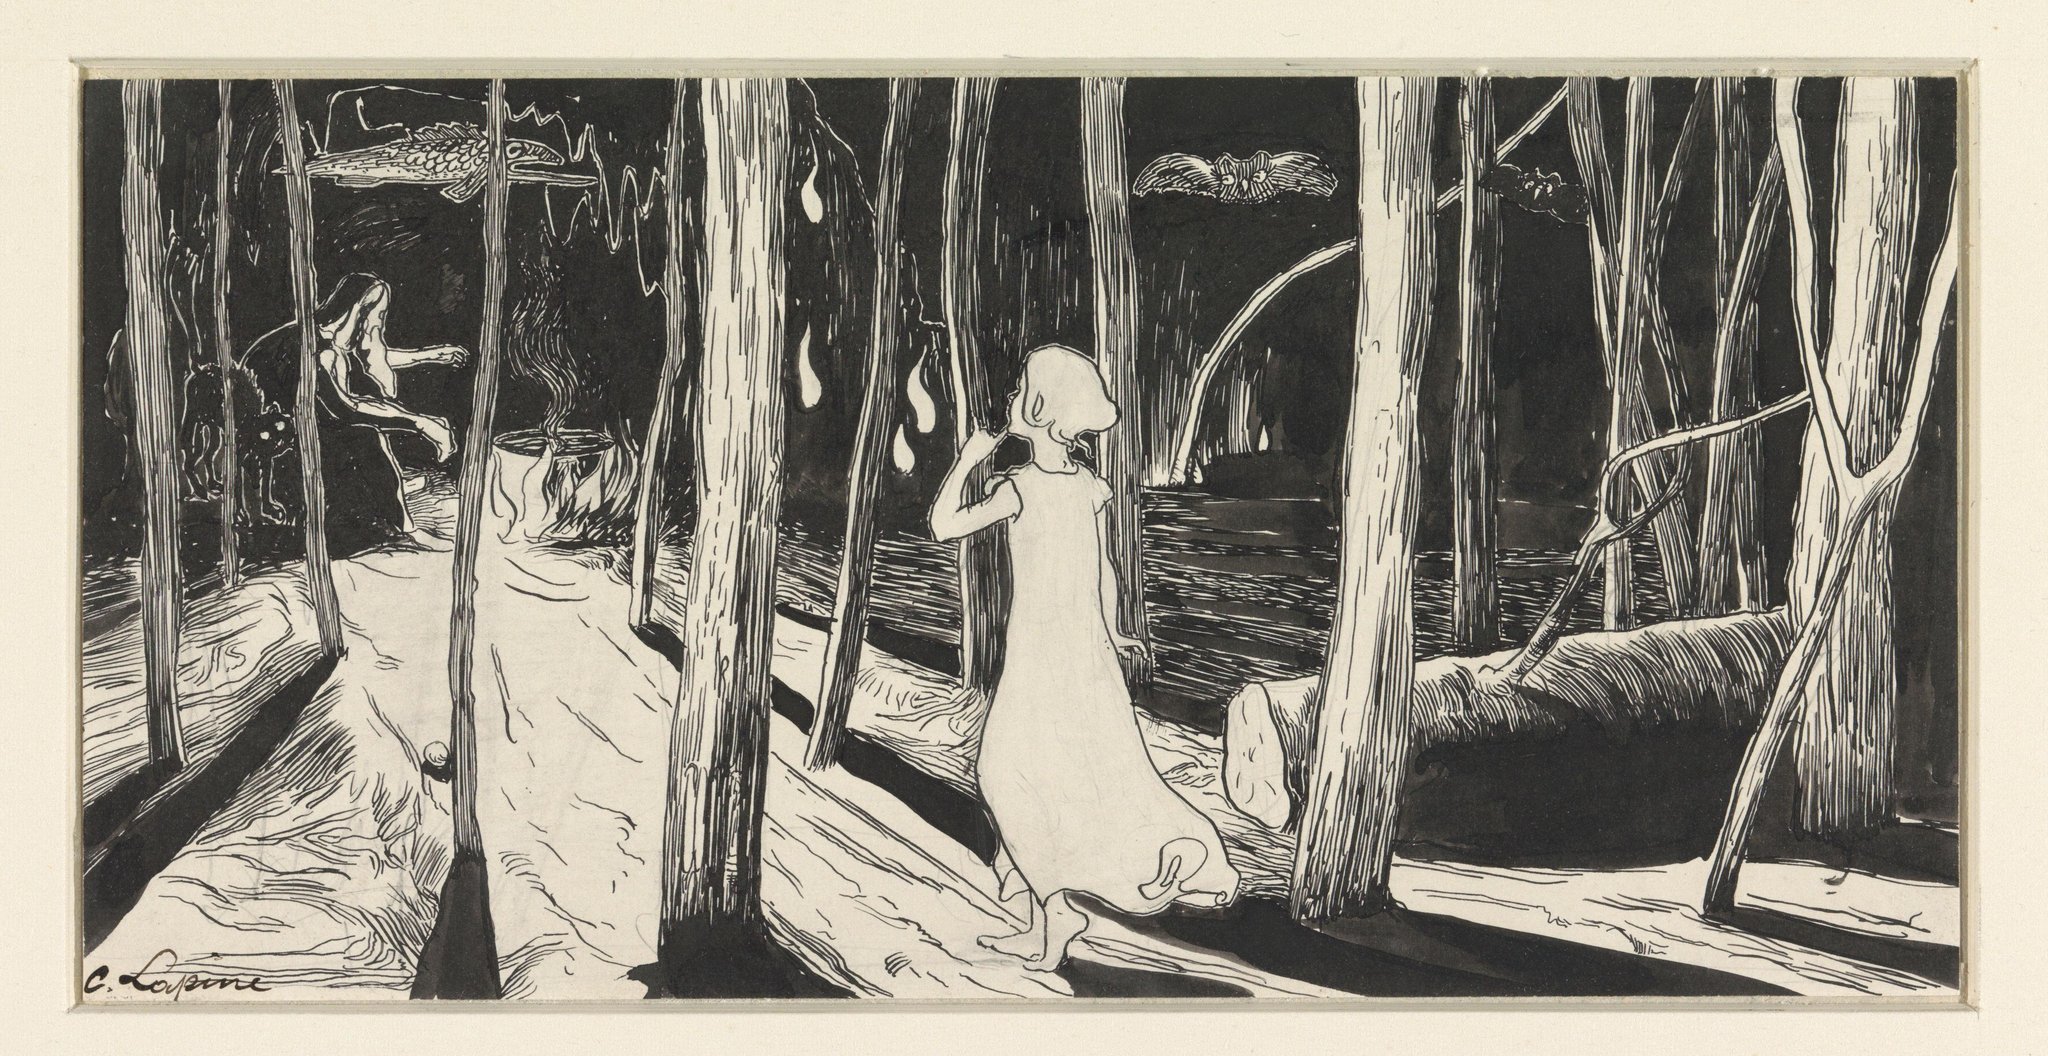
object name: drawing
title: Heks bij kookpot in bos bij nacht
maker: c. lapine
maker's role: draughtsman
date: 1895-1900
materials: ink, paper, pencil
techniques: brush, pen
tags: brewing, boiling (in a cauldron); witches' kitchen